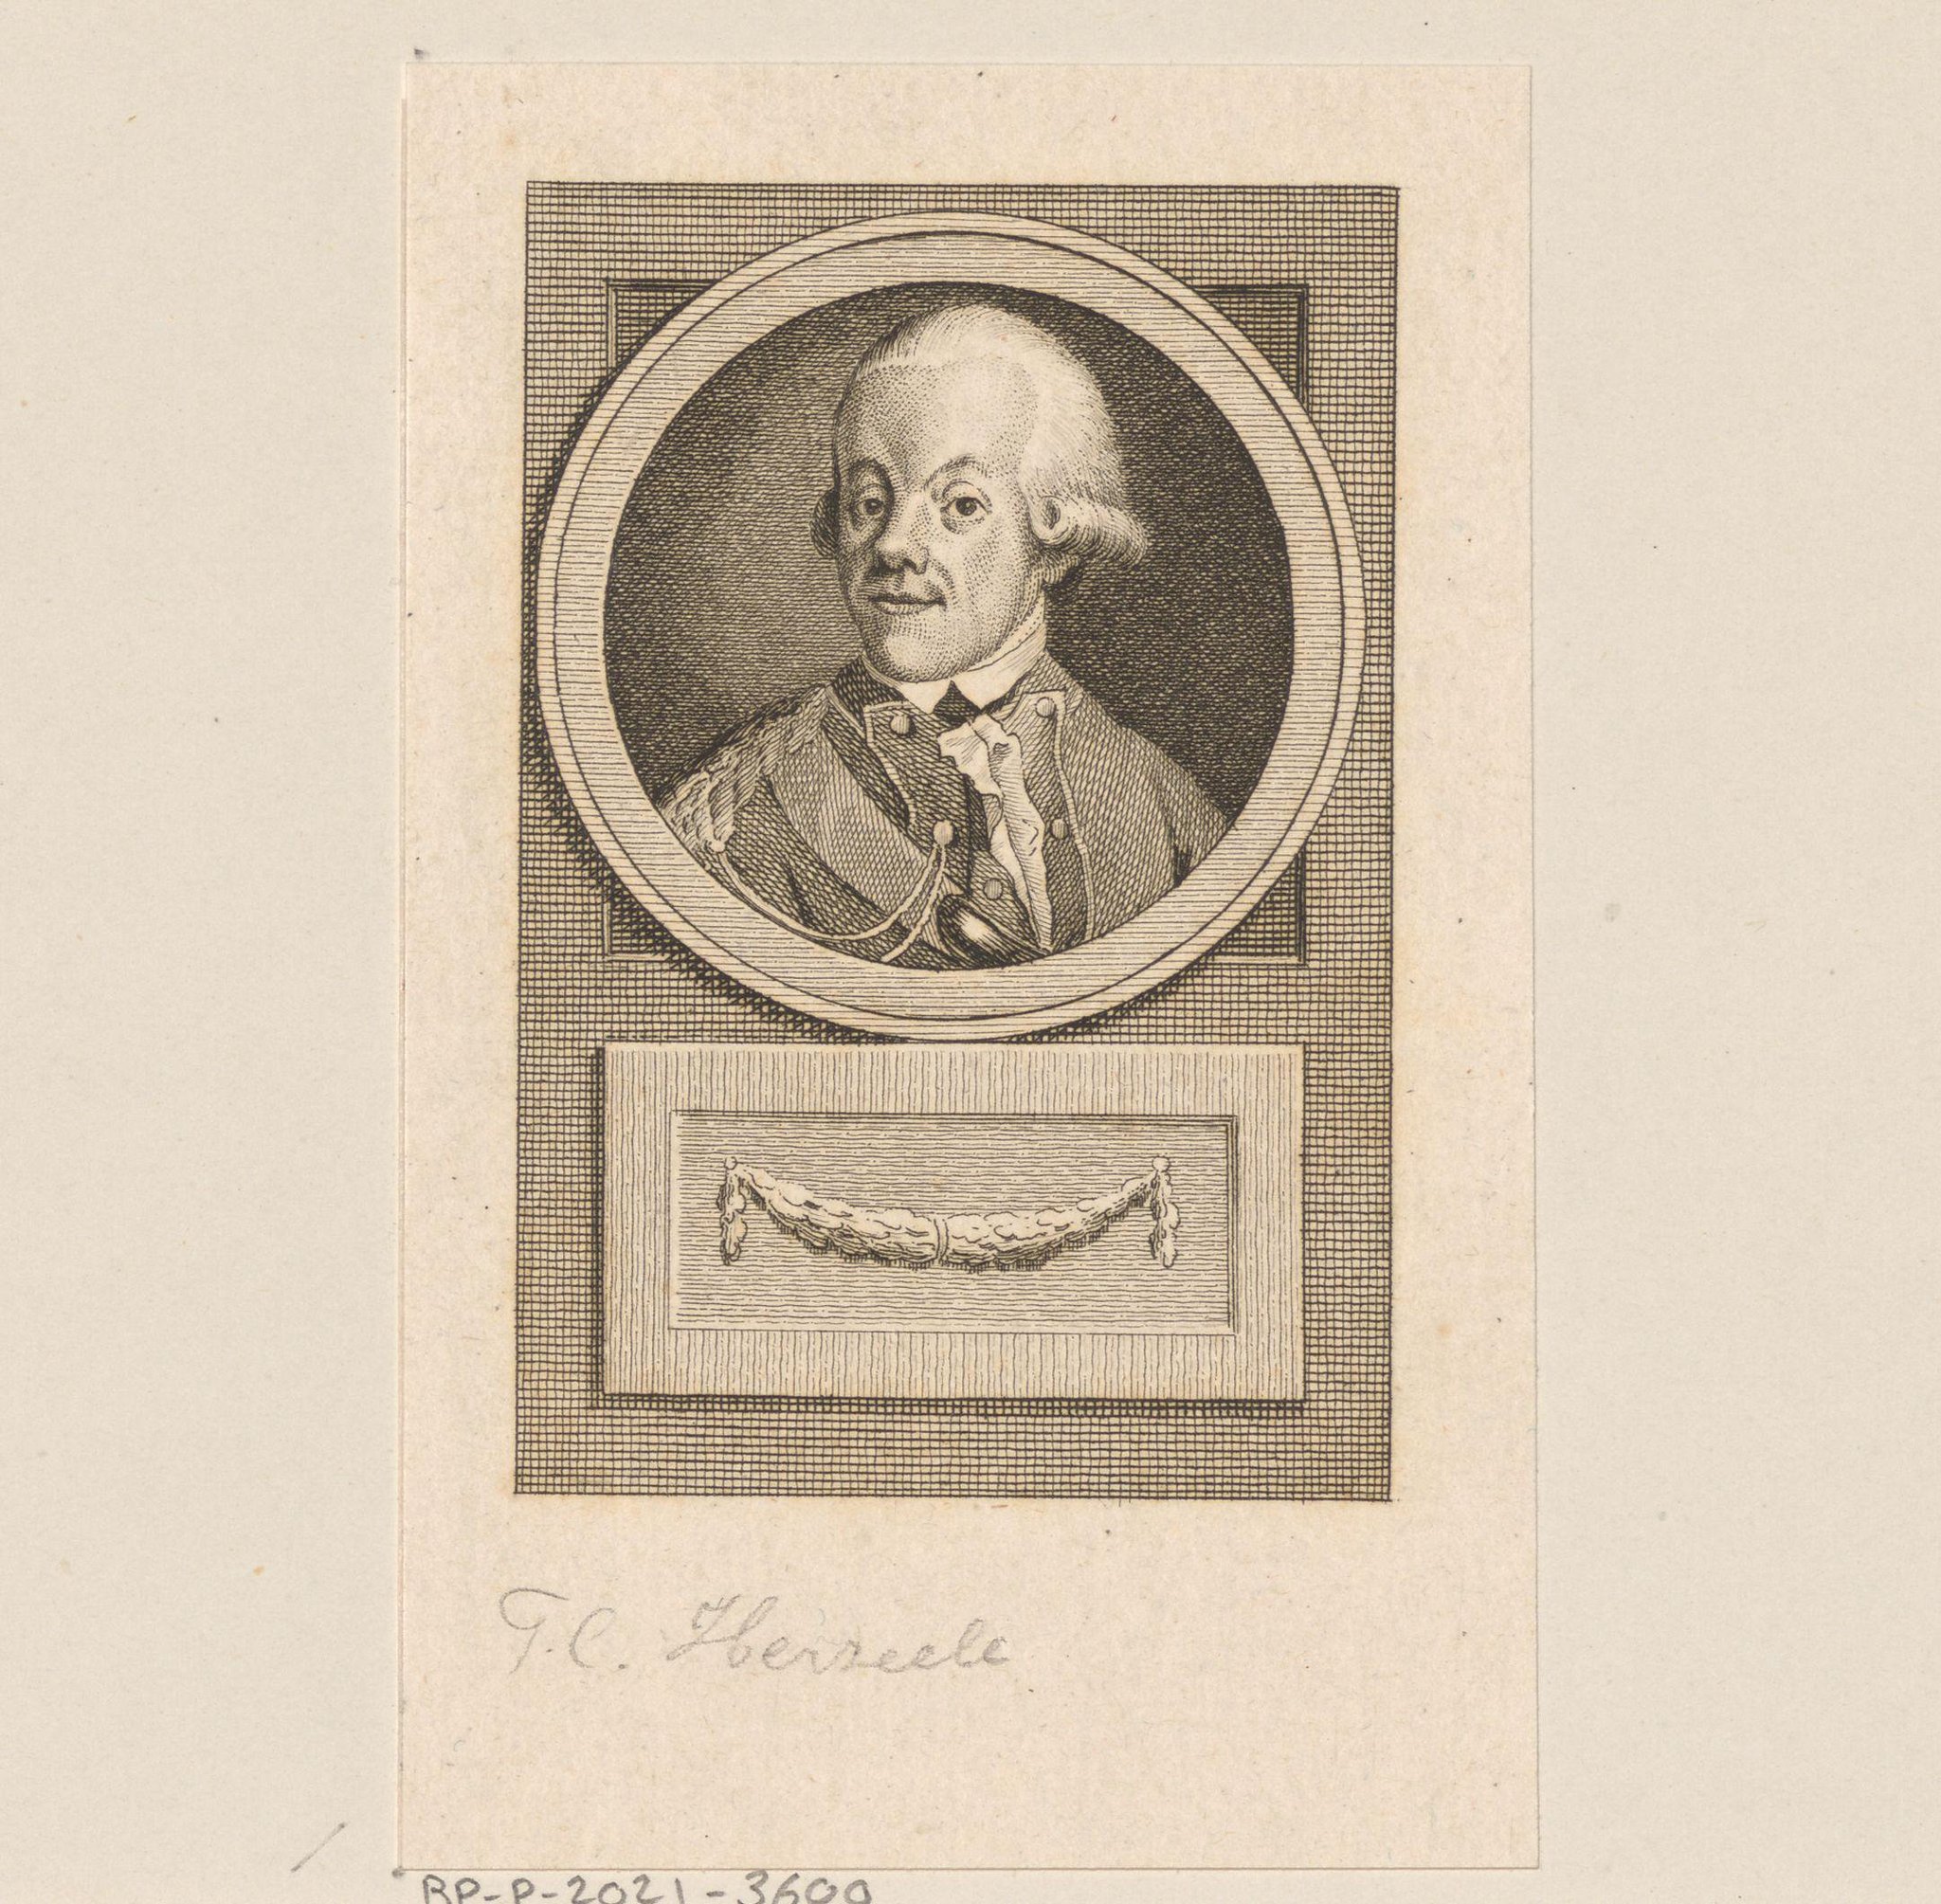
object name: print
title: Portret van Theodorus Cornelis van Herzeele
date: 1783-1795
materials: paper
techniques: engraving, etching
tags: historical persons, officer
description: Latere staat gebruikt in: Fokke, Jan. Geschiedenissen der Vereenigde Nederlanden voor de vaderlandsche jeugd (...). Amsterdam: Johannes Allart, 1783-1795, dl. 13.